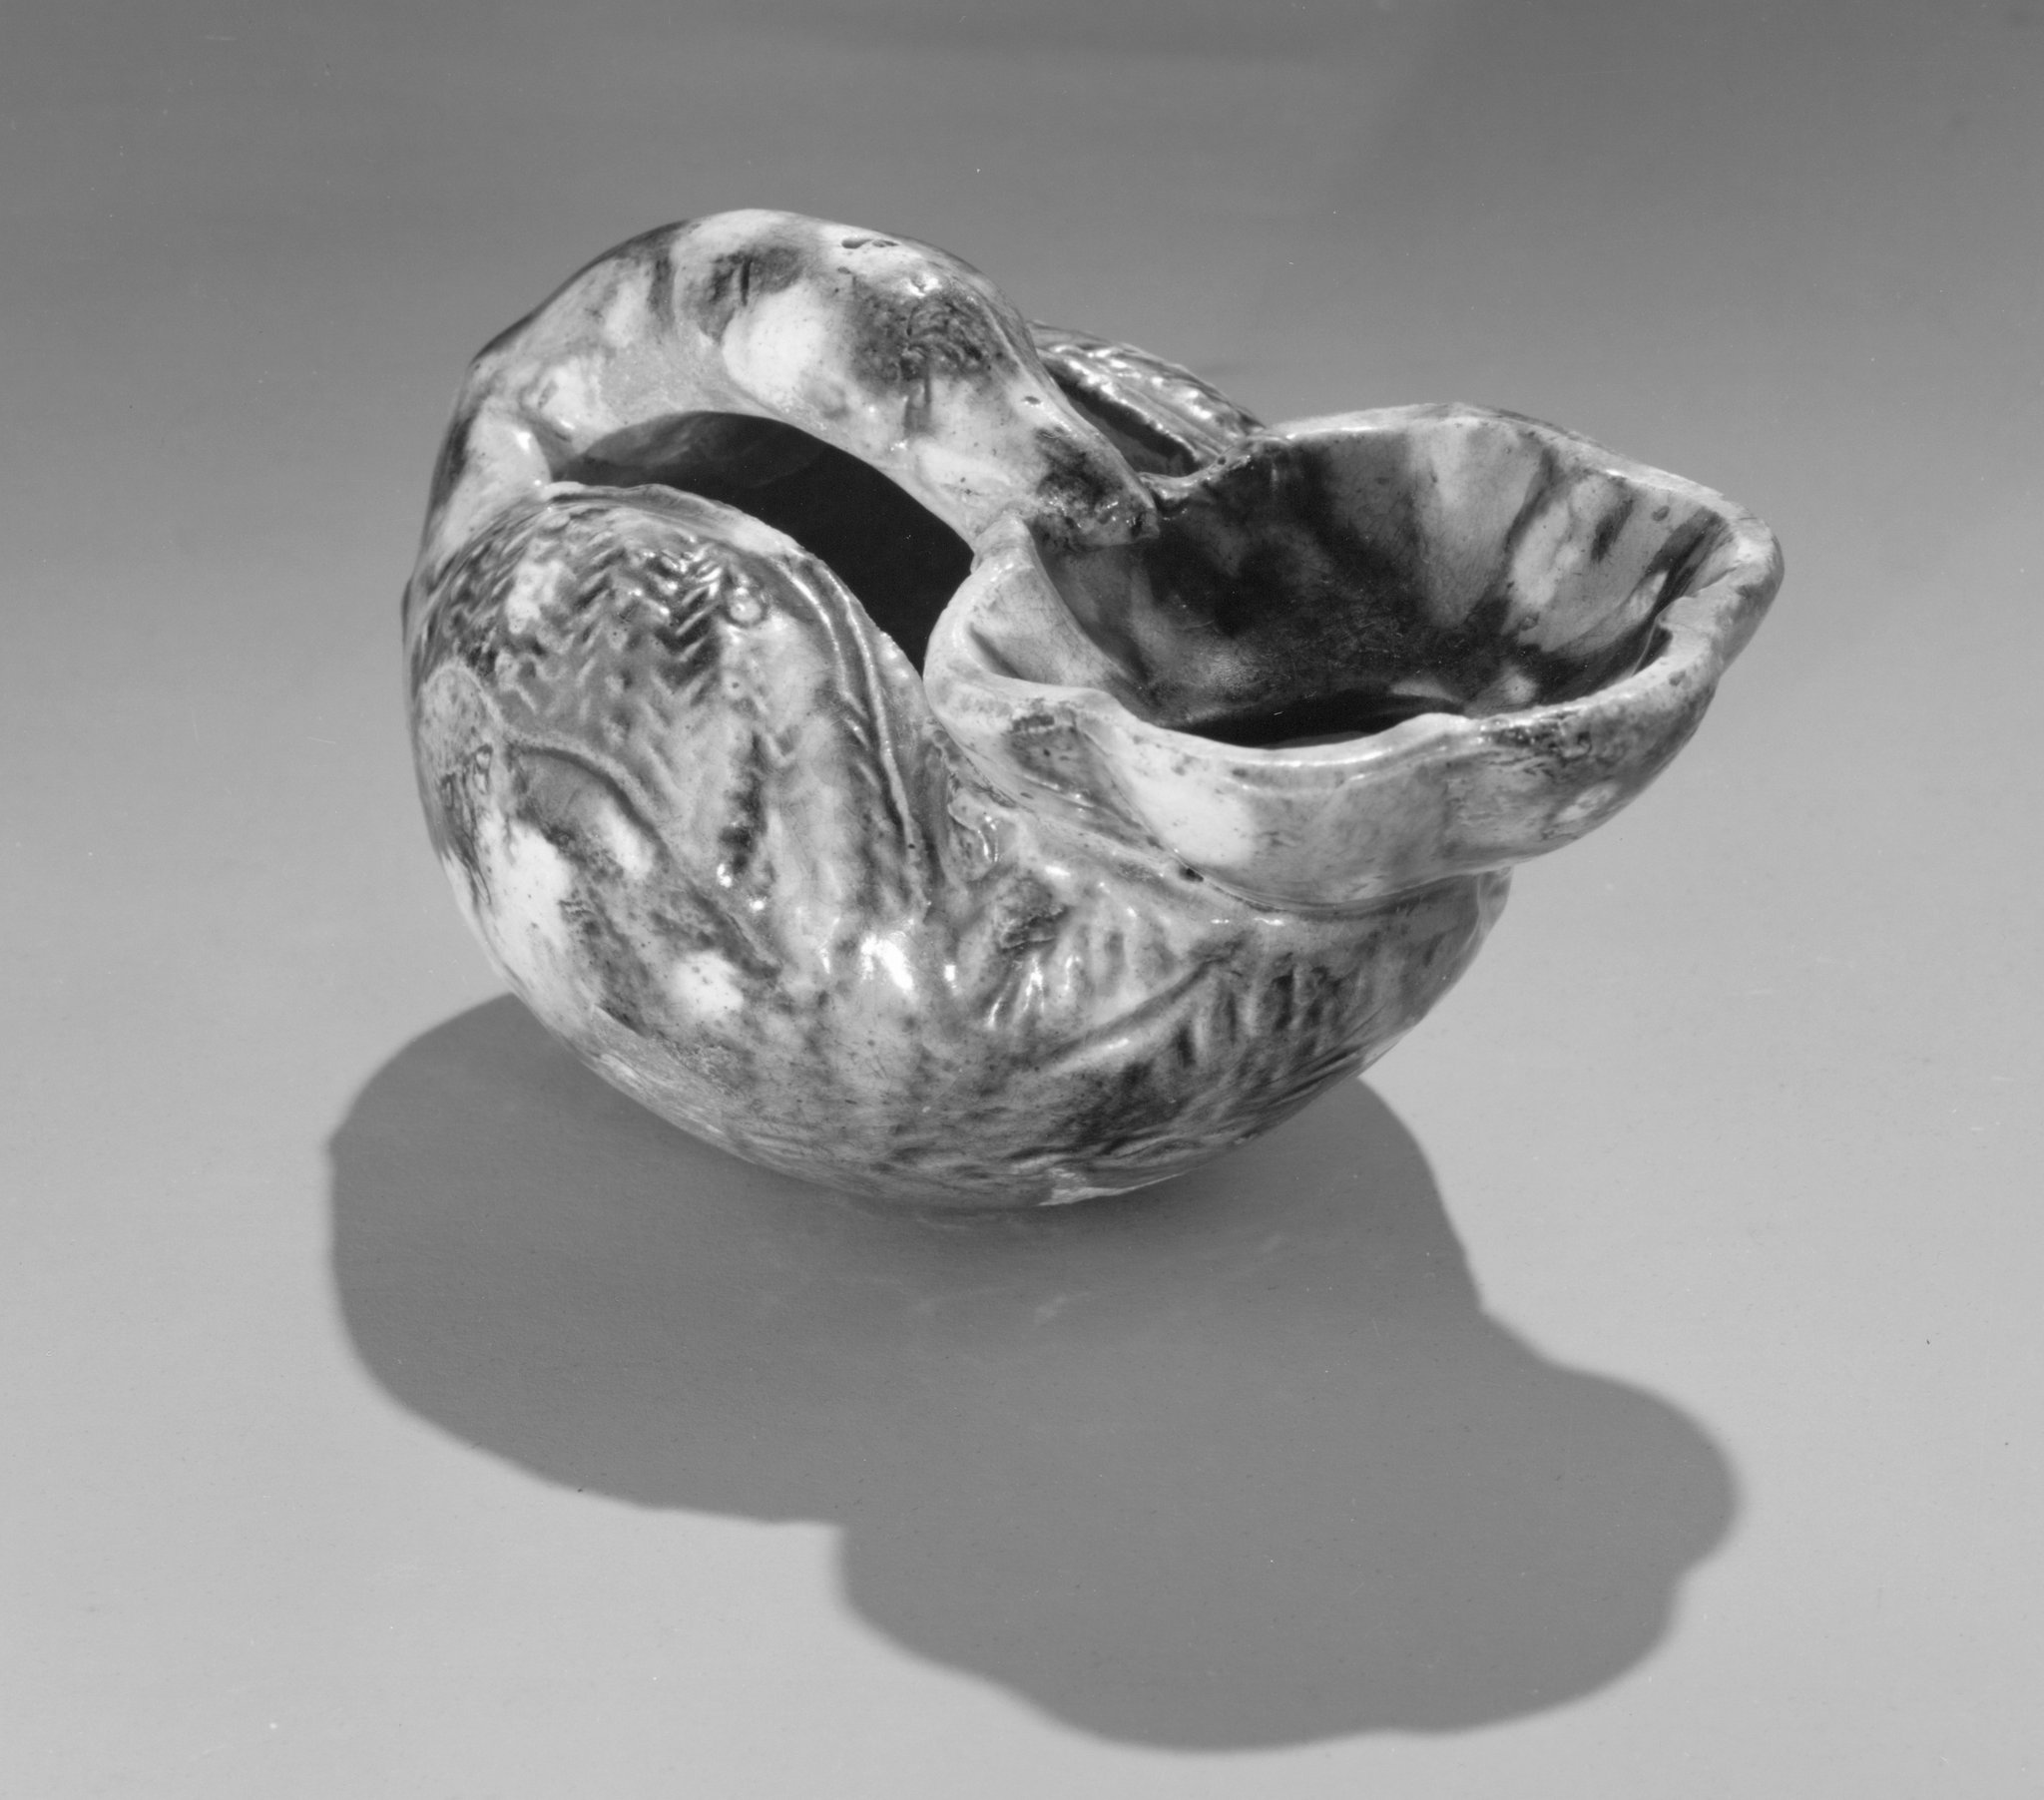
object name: rhyton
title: Rhyton in the shape of a bird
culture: chinese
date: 601-800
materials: earthenware, glaze